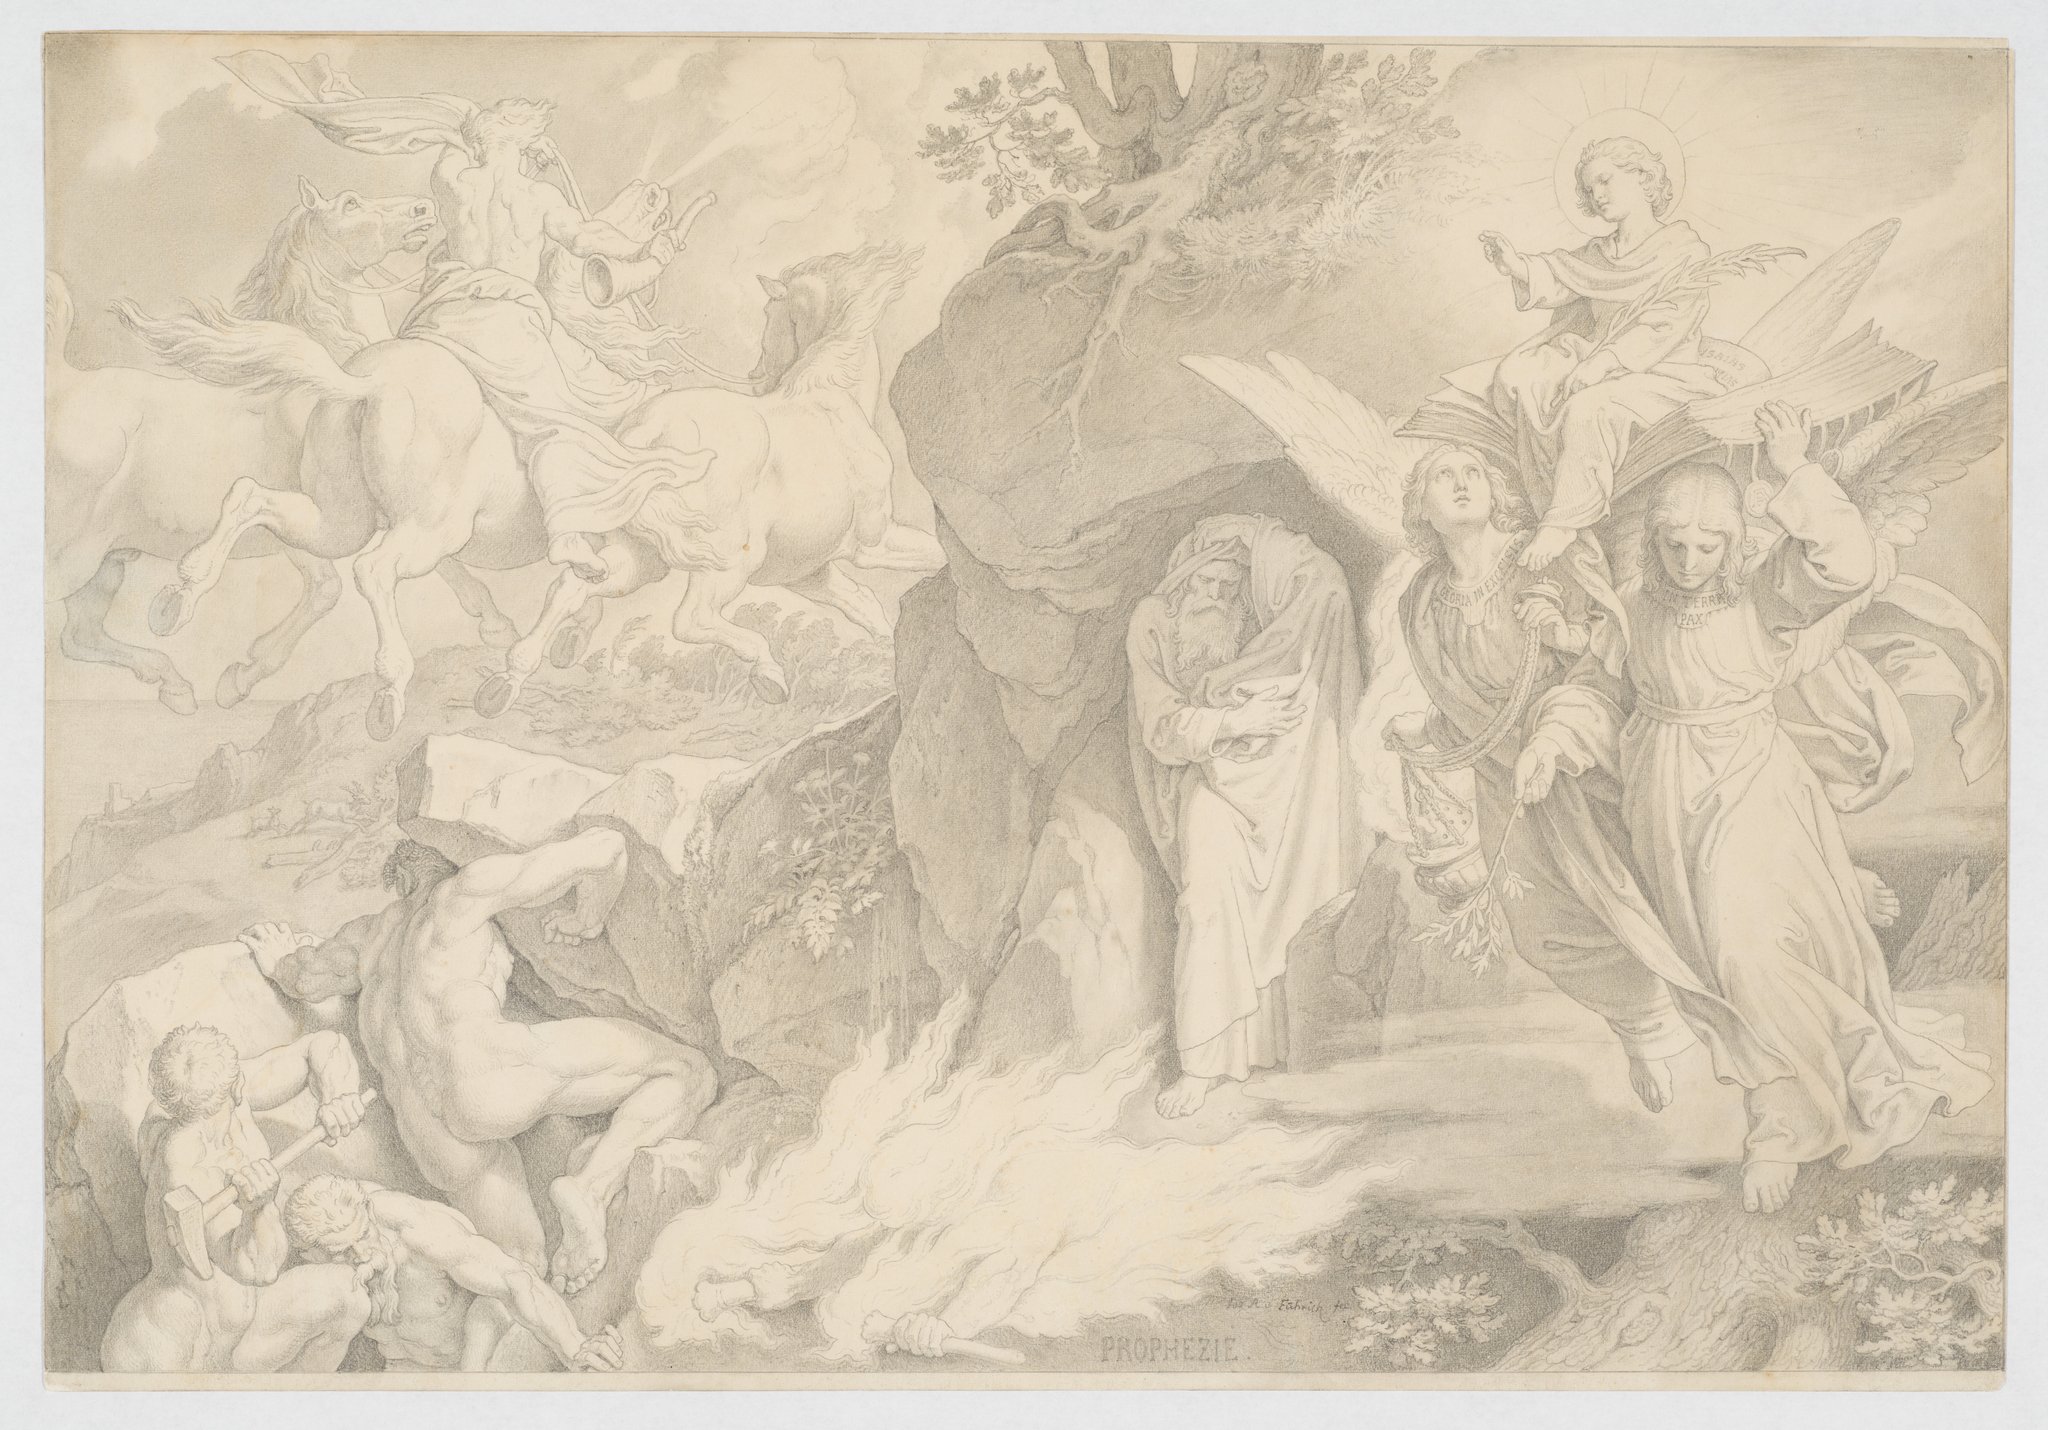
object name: drawing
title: Prophesie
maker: joseph von führich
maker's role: artist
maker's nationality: austrian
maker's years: 1800-1876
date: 1839-1840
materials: graphite, paper